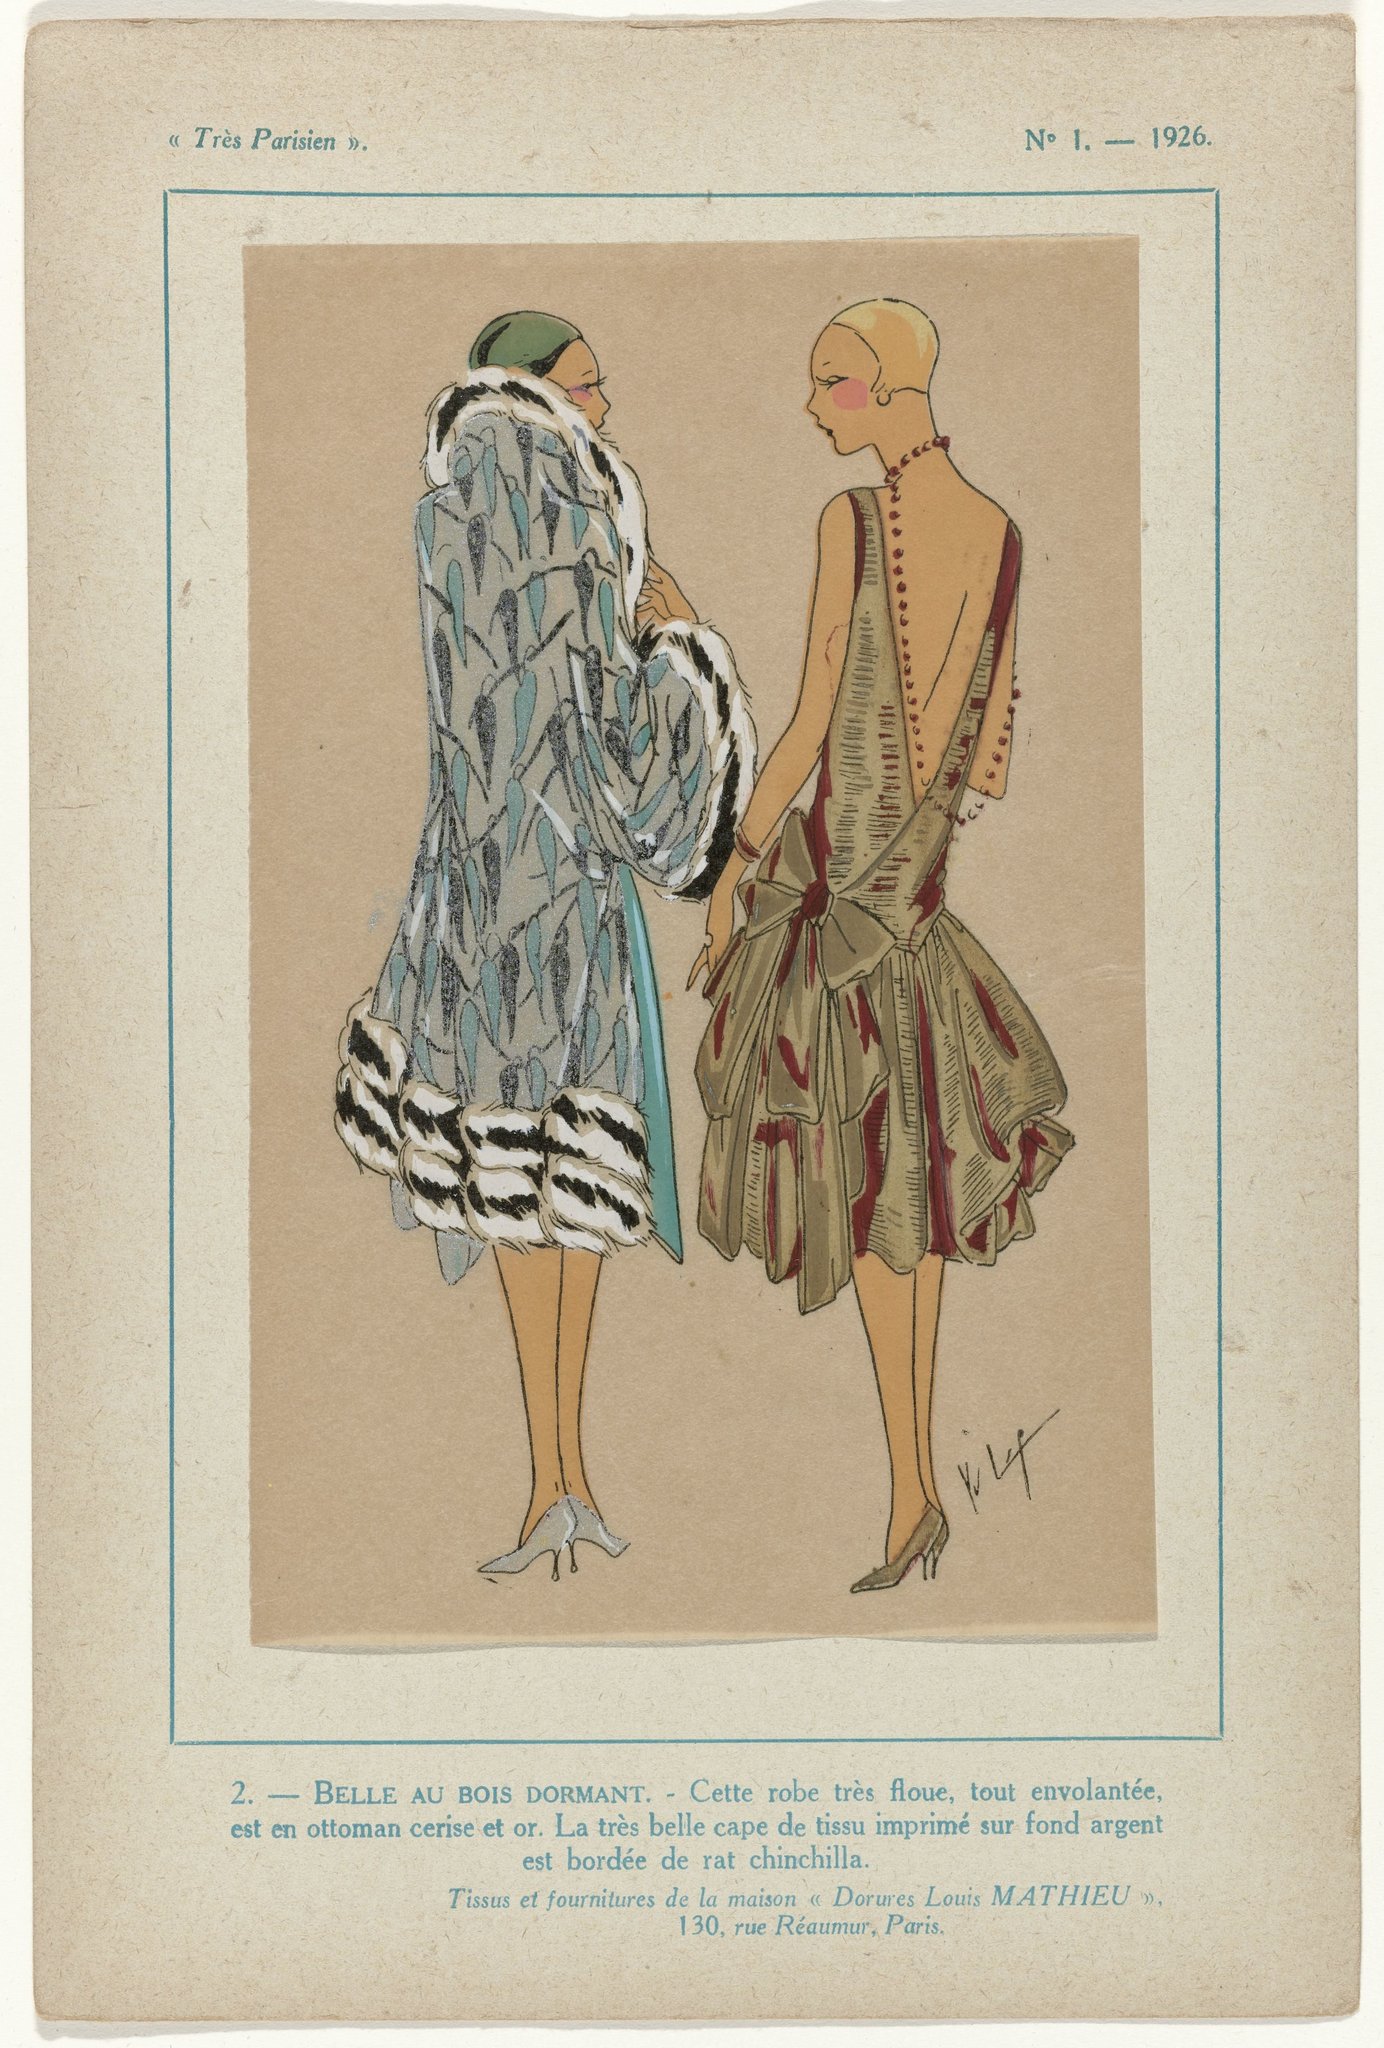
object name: fashion print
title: Très Parisien, 1926, No. 1, Pl. 1.- BELLE AU BOIS DORMANT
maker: g-p. joumard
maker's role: publisher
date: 1926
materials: paper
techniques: hand coloring, letterpress printing, lithography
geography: paris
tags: dress, gown: dinner dress (+ women's clothes), coat (evening coat) (+ women's clothes), fashion plates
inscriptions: title: ‘BELLE AU BOIS DORMANT’, caption: ‘maison "Dorures Louis Mathieu, 130 , rue Reaumur, Paris.’, caption: ‘Cette robe très floue, tout envolantée, est en ottoman cerise et or. La très belle cape de tissu imprimé sur fond argent est bordée de rat chinchilla.’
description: Japon met volants en grote strik aan de linkerzijde, laag uitgesneden rug; mantel met zilver bedrukt, afgezet met chinchilla. Stoffen van maison "Dorures Louis Mathieu, 130 , rue Reaumur, Paris. " Prent uit het modetijdschrift Très Parisien...La Mode, Le Chic, L'Élégance (1920-1936)